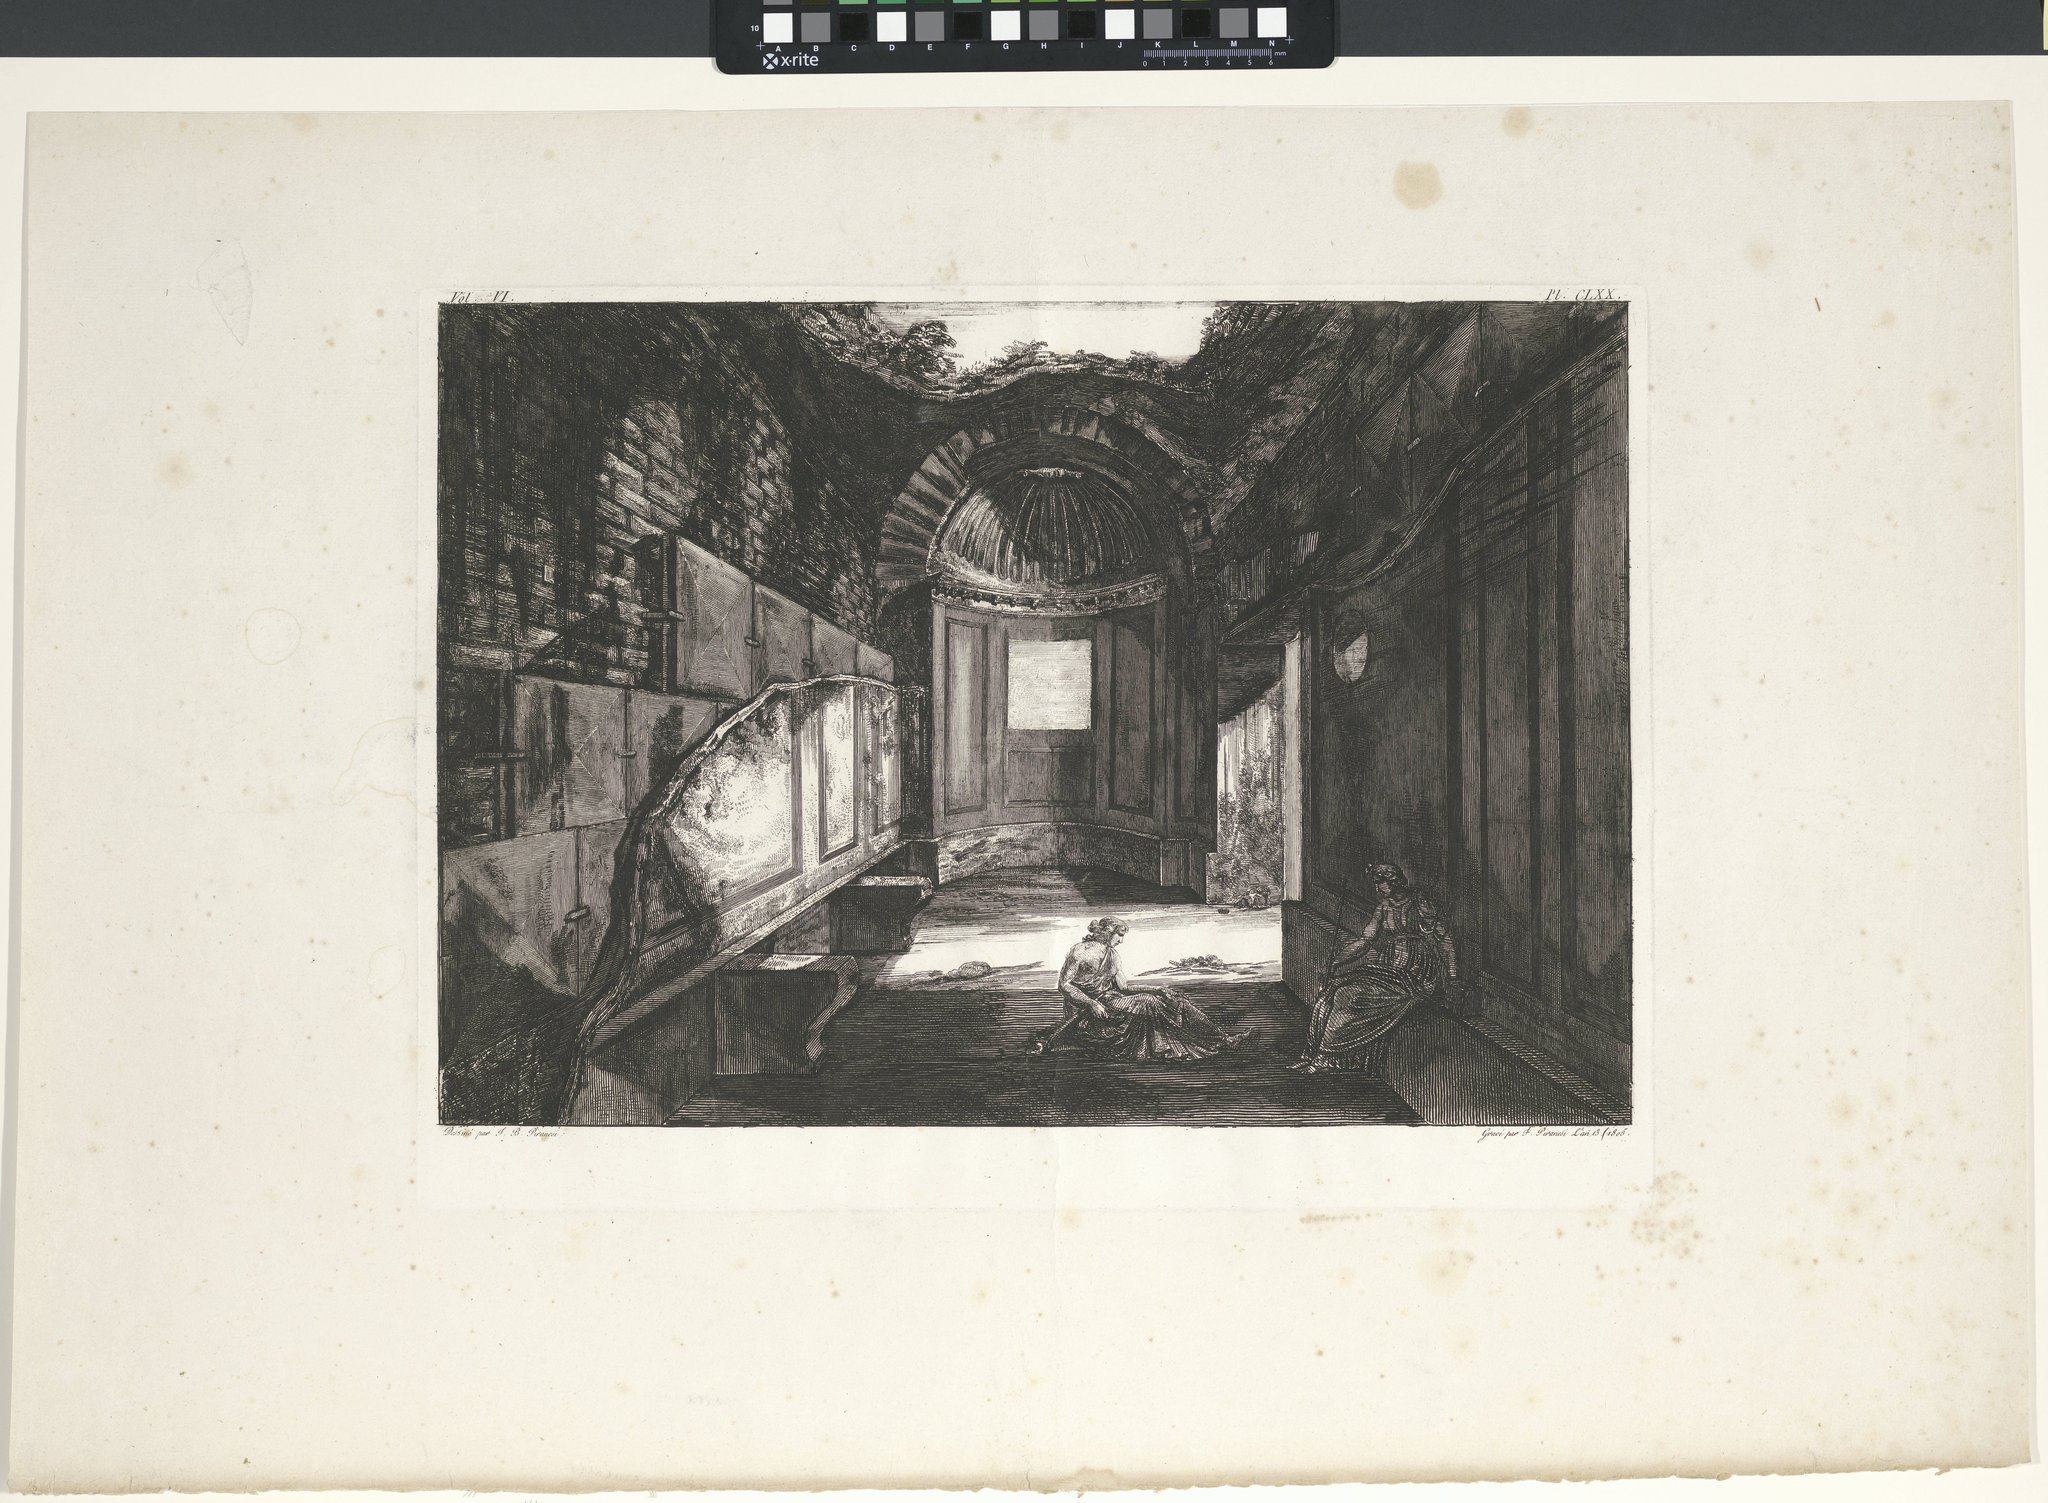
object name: print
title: Twee vrouwen in een vervallen tempel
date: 1805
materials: paper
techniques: etching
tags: temple, shrine ~ roman religion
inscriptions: collector's mark: Lugt 2228, collector's mark: Lugt 2760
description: Rechtsboven genummerd: Vol. VI. Linksboven genummerd: Pl. CLXX.